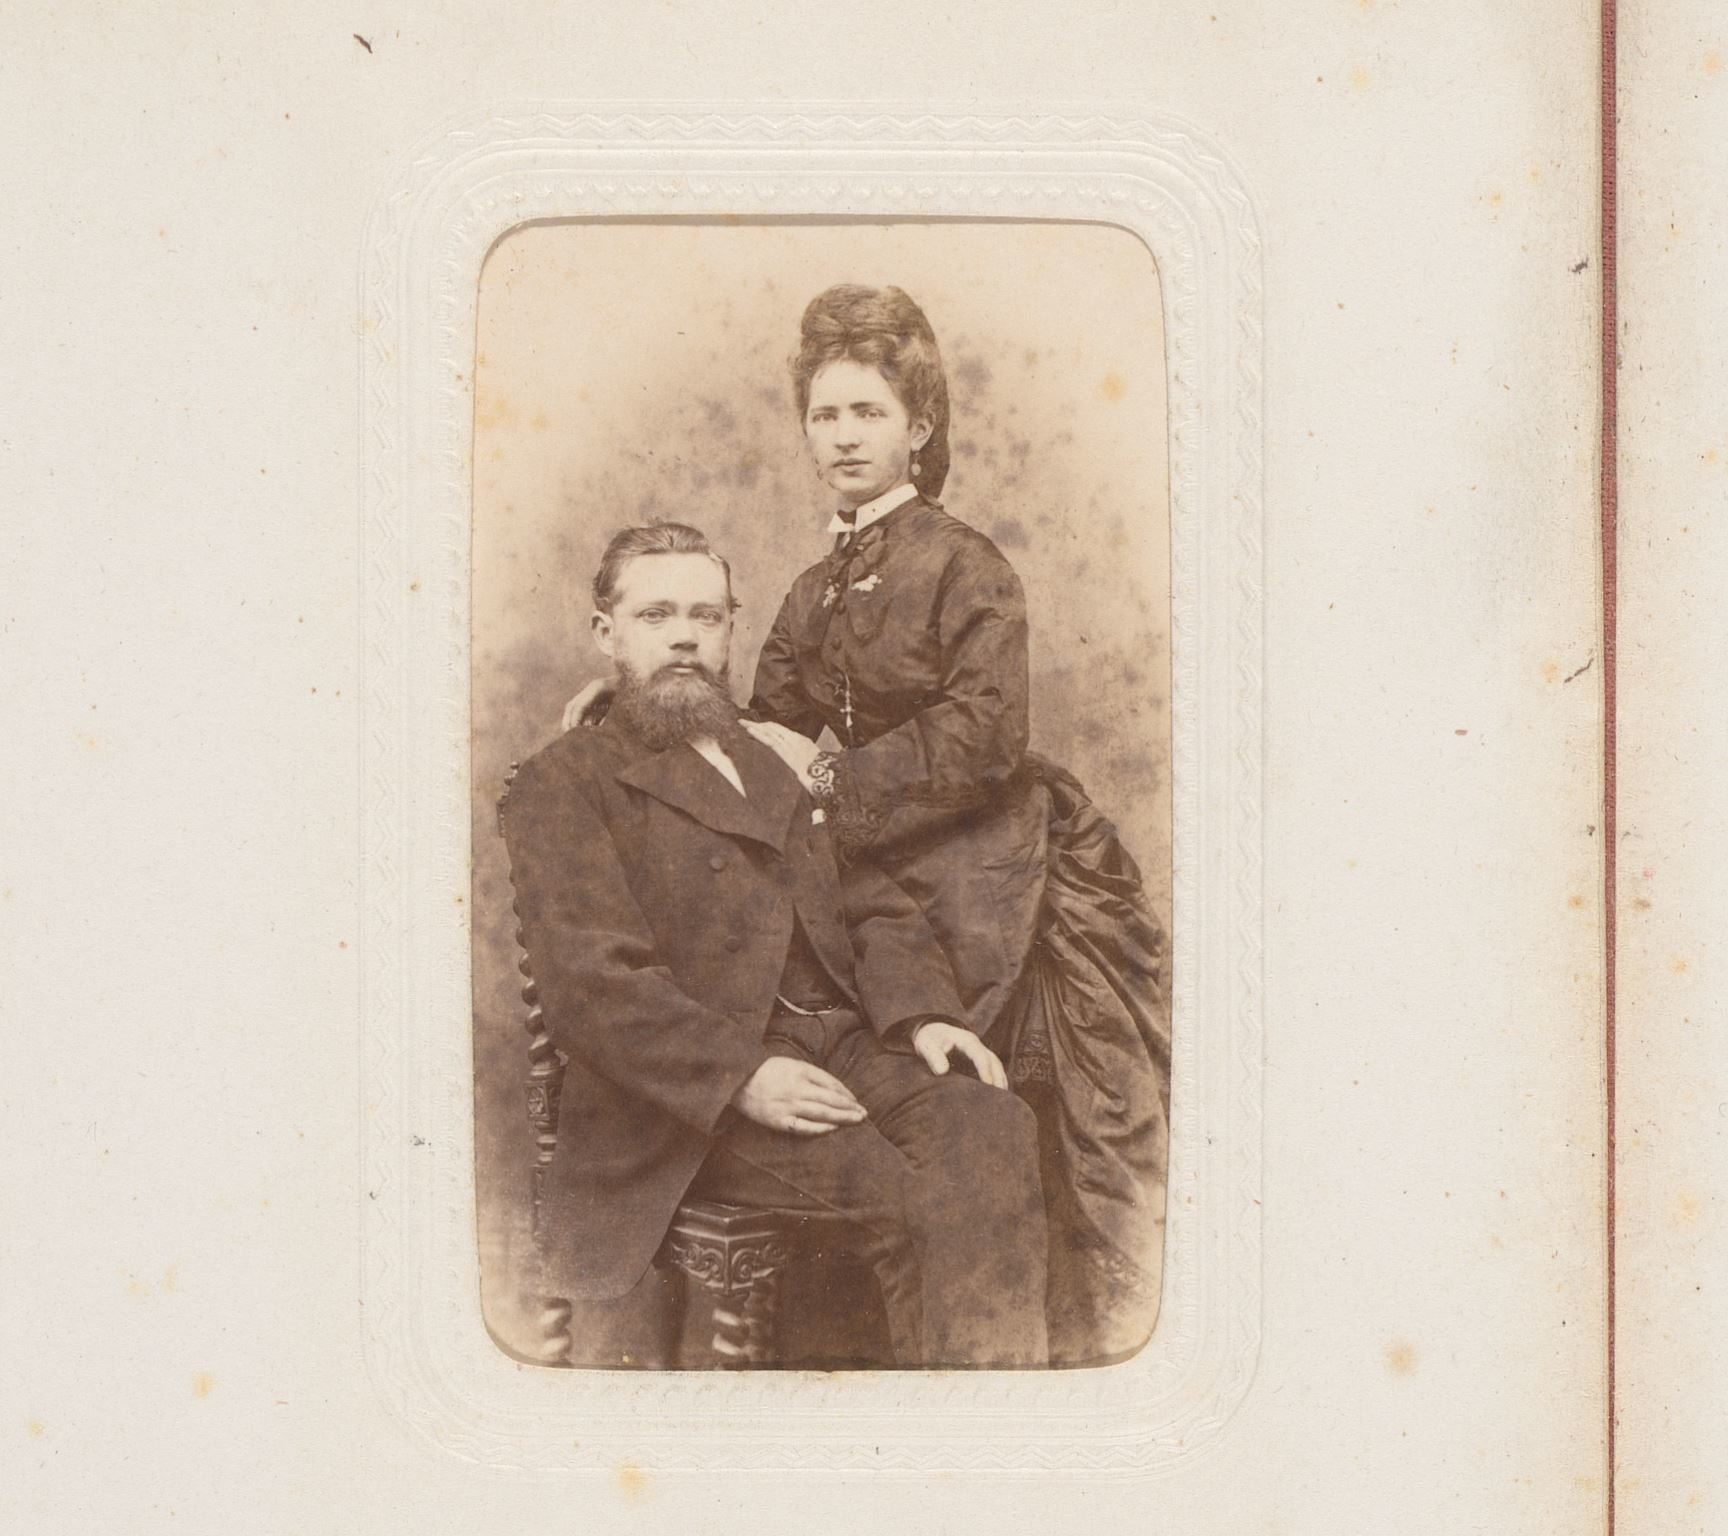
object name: photograph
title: Portret van een zittende man en een staande vrouw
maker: ernst wolffram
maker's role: fotograaf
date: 1850-1900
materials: cardboard, photographic support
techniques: albumen print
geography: bremen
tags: sitting figure, historical persons - bb - woman, historical persons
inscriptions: inscription: ‘[...]/ der Originalplatte./ E. WOLFFRAM/ Fedelhören 14./ PARTERRE.’